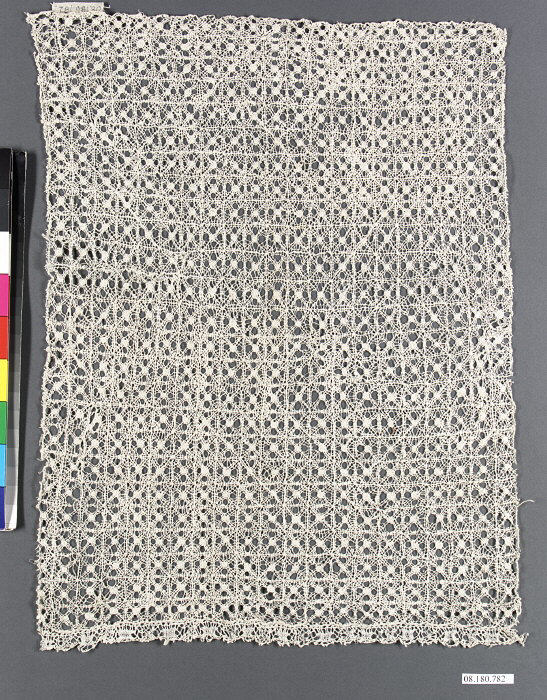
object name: fragment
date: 1601-1700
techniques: embroidery